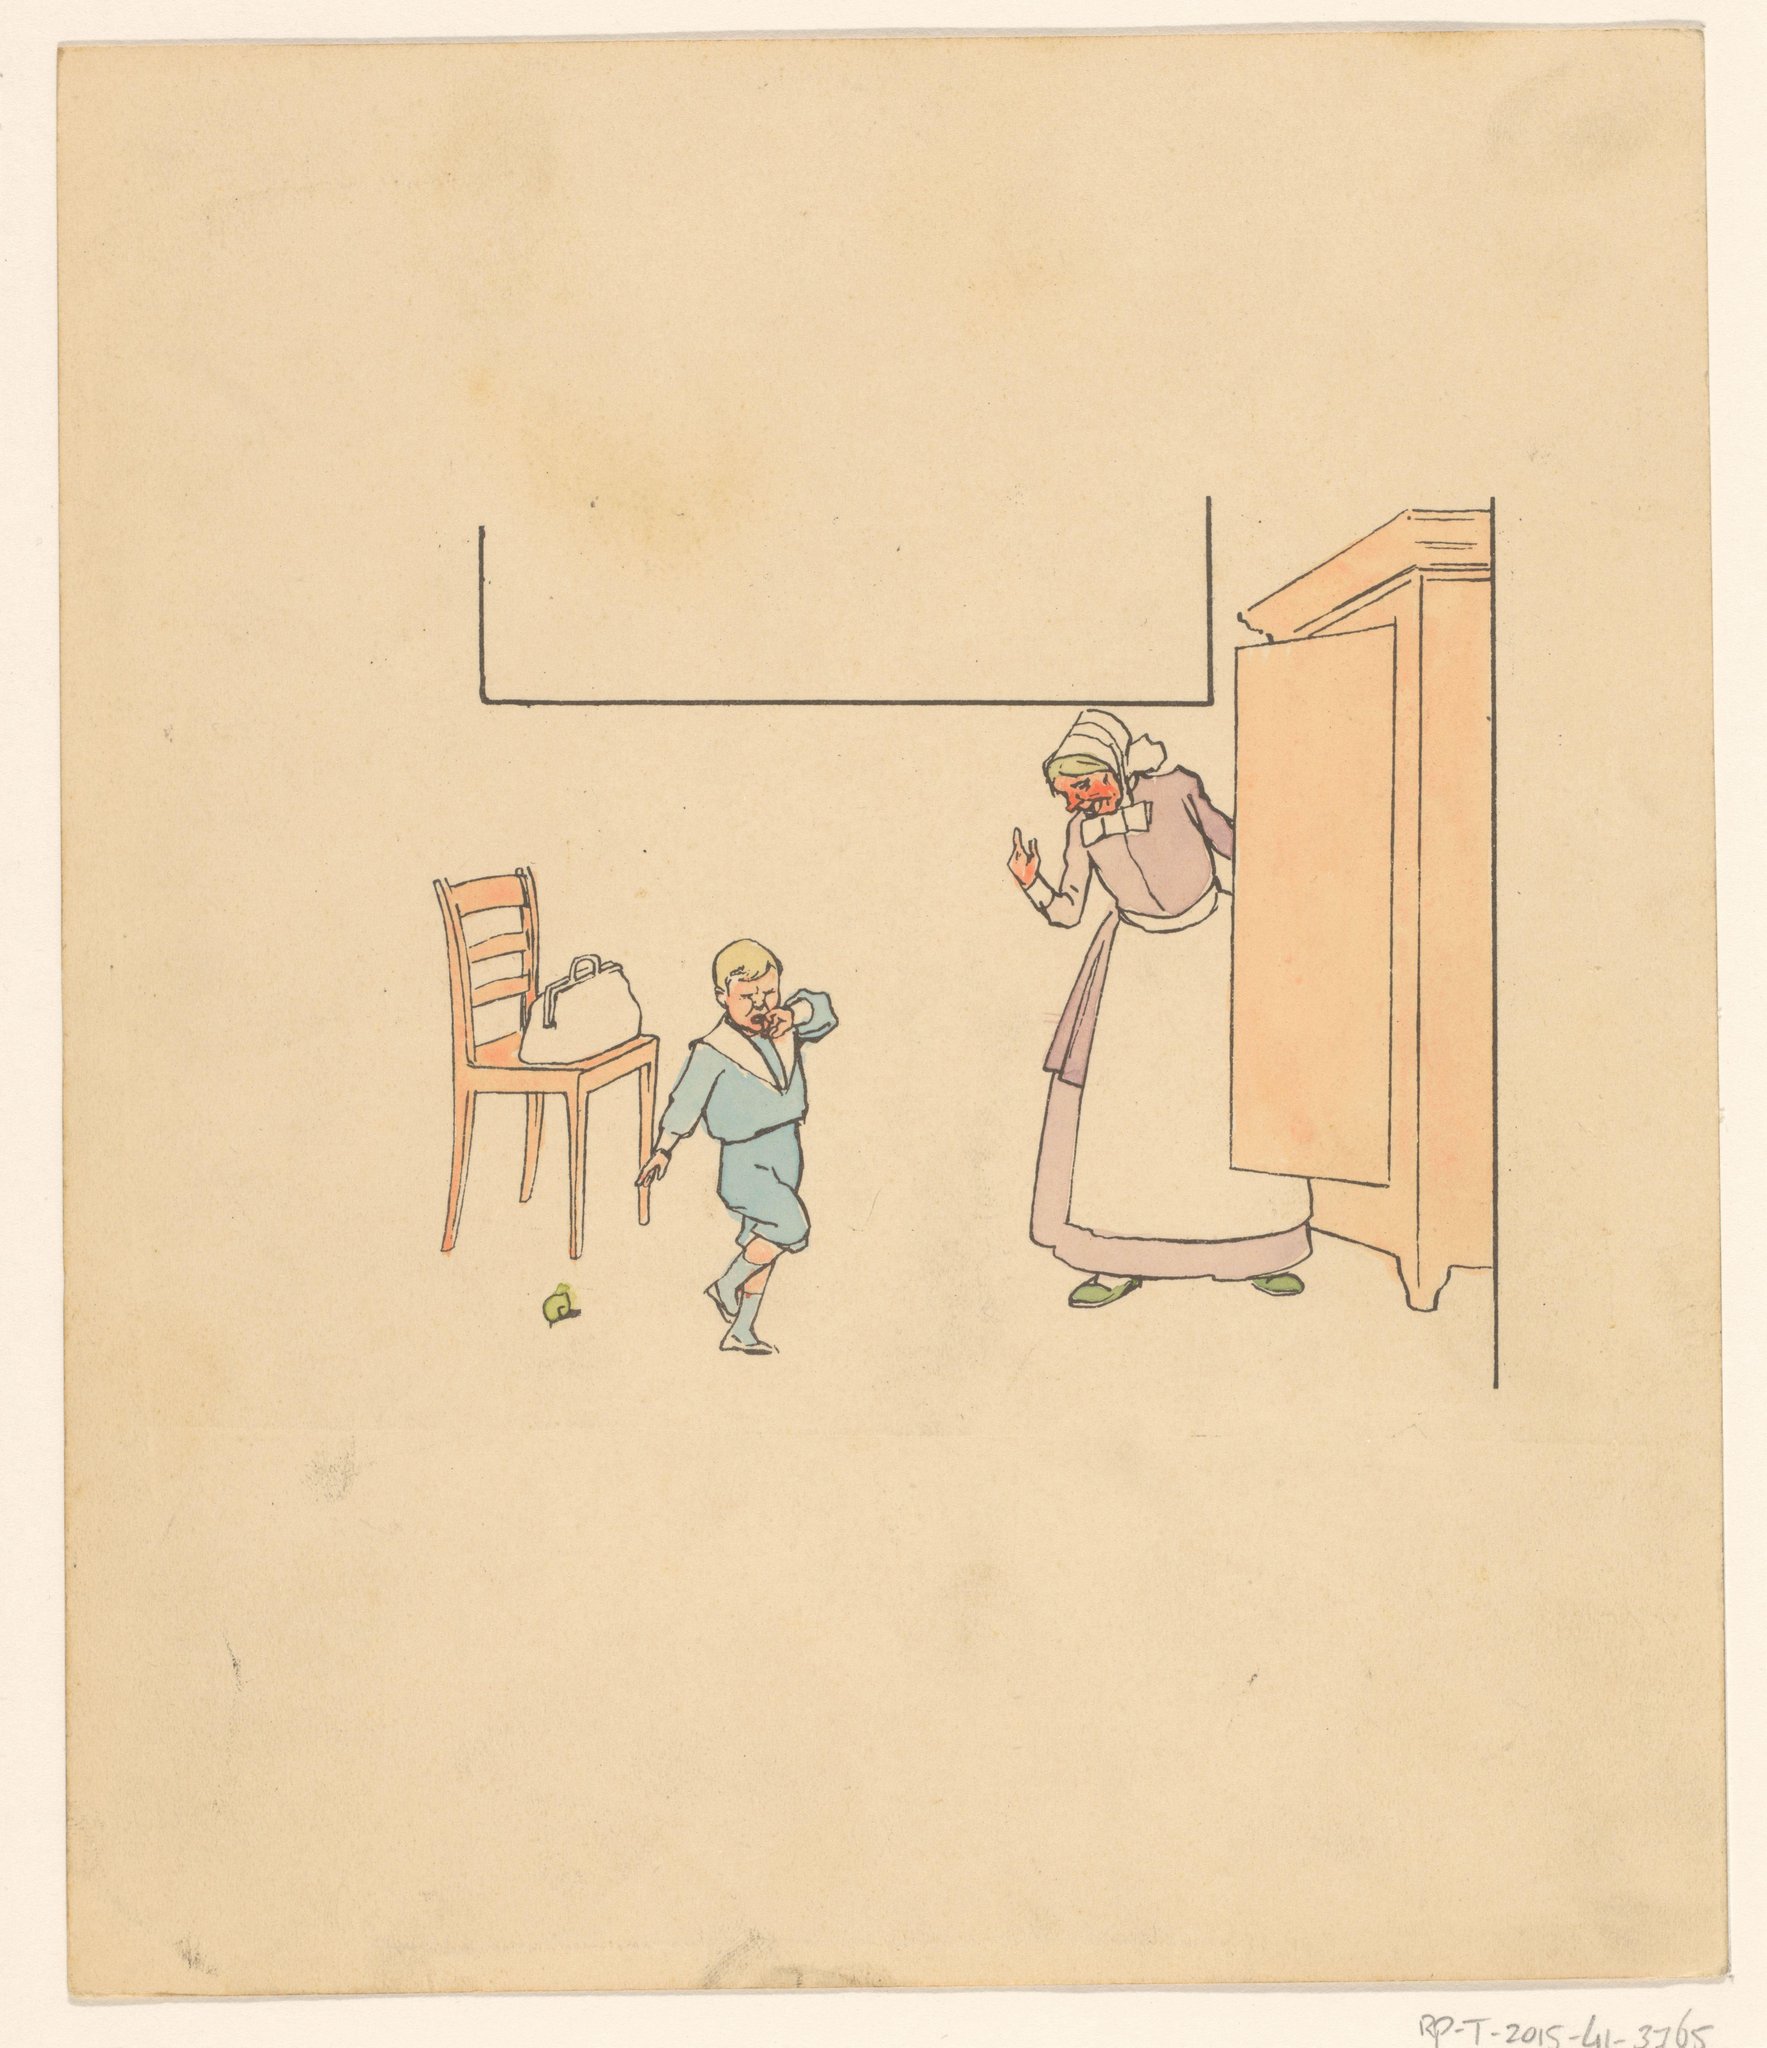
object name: boekillustratie ontwerp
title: Vrouw en huilende jongen bij een kast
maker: Anonymous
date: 1880-1910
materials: ink, paper, watercolor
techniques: brush, pen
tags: wardrobe, weeping, fruits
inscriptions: collector's mark: Lugt 2228a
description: Een vrouw pakt iets uit een kast. Ze staat half naar een huilende jongen gekeerd. Op de grond naast de jongen ligt een stuk fruit.